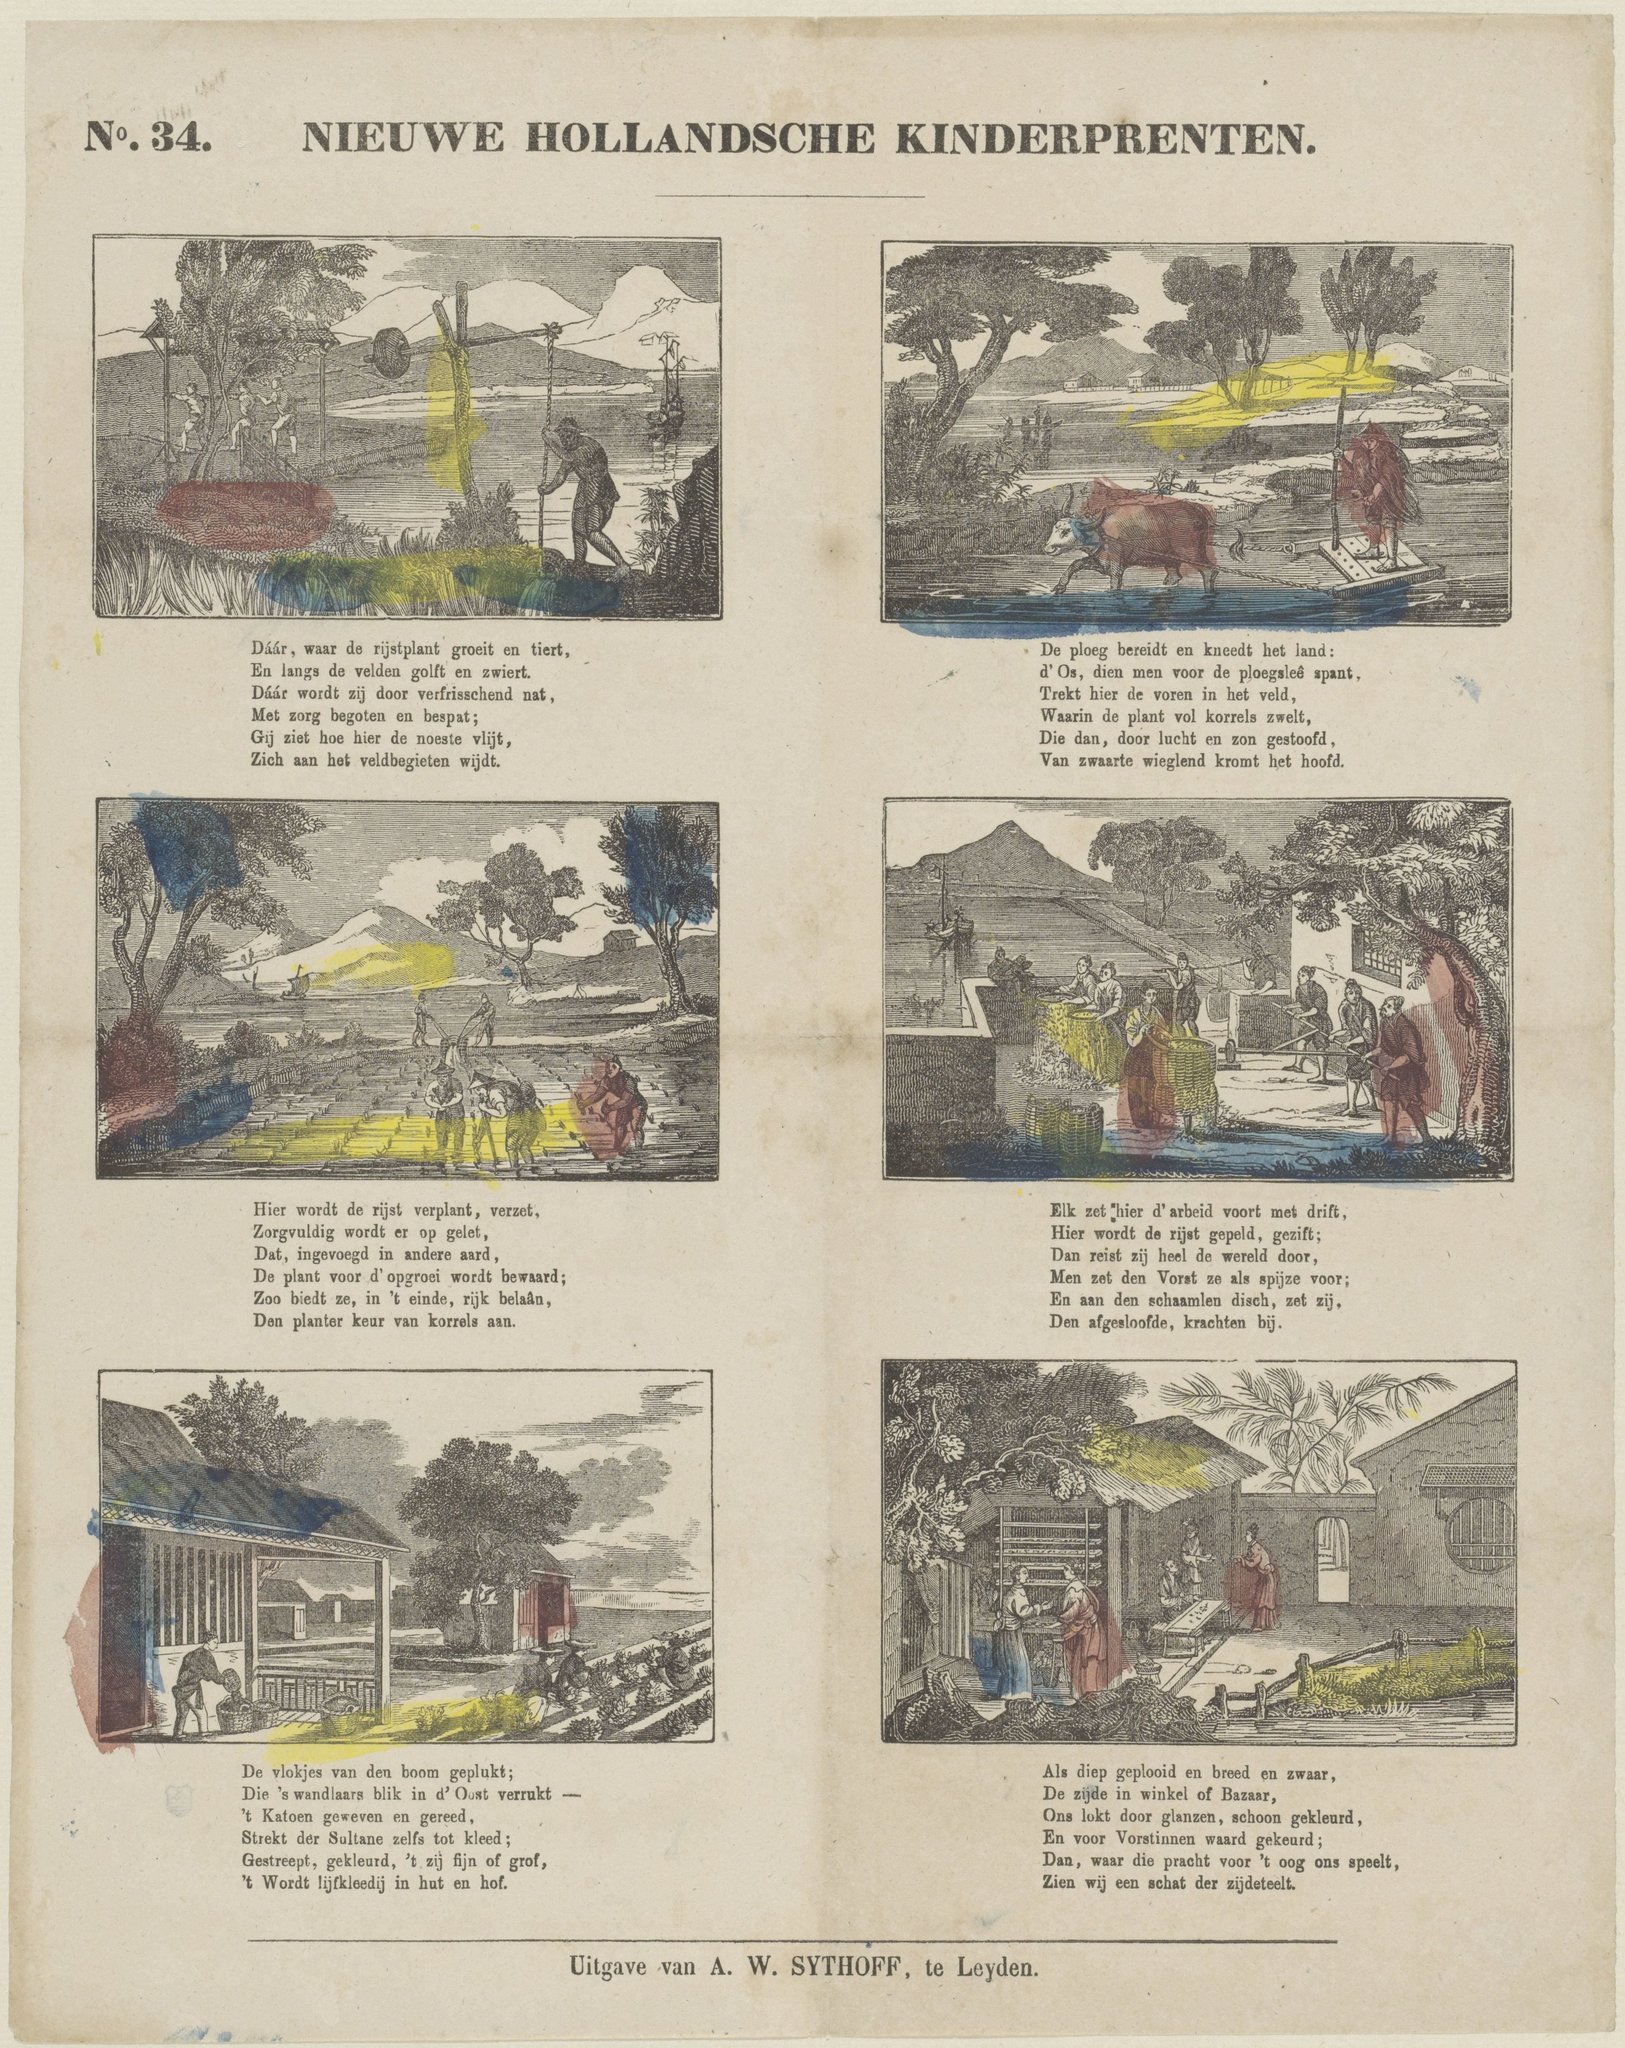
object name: popular print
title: Dáár, waar de rijstplant groeit en tiert [(...)]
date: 1861-1929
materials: paper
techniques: colour, letterpress printing, engraving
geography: leiden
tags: cereal, grain, corn (grass with grains, grown for food, e.g.: wheat, rice, rye, oats, maize, buckwheat, millet) (+ labourers ~ crafts, industries, agriculture), sawahs, rice paddies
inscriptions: collector's mark: Lugt 2760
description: Blad met 6 voorstellingen van de rijstproductie in Azië. Onder elke voorstelling een zesregelig vers. Genummerd linksboven: No. 34.